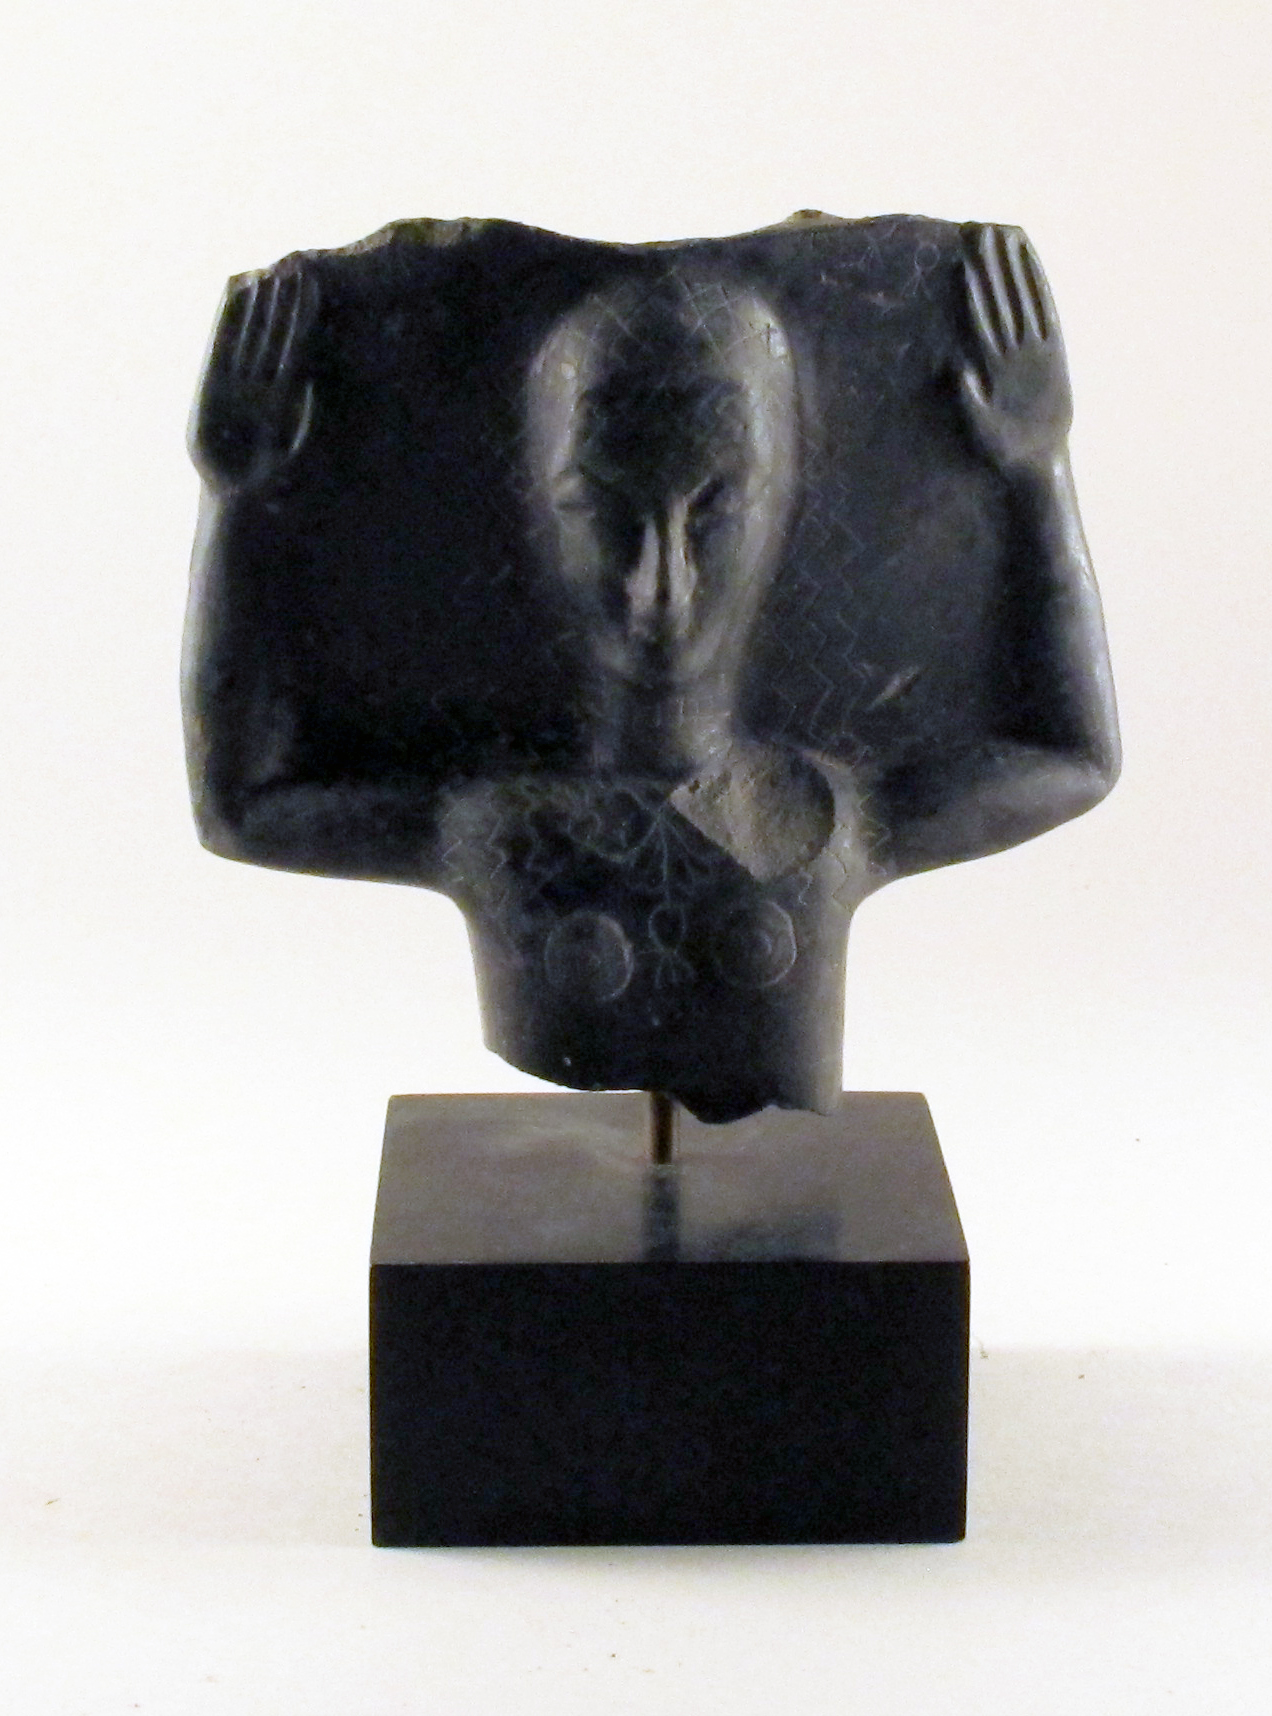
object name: vase fragment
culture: etruscan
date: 501-600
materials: terracotta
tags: women